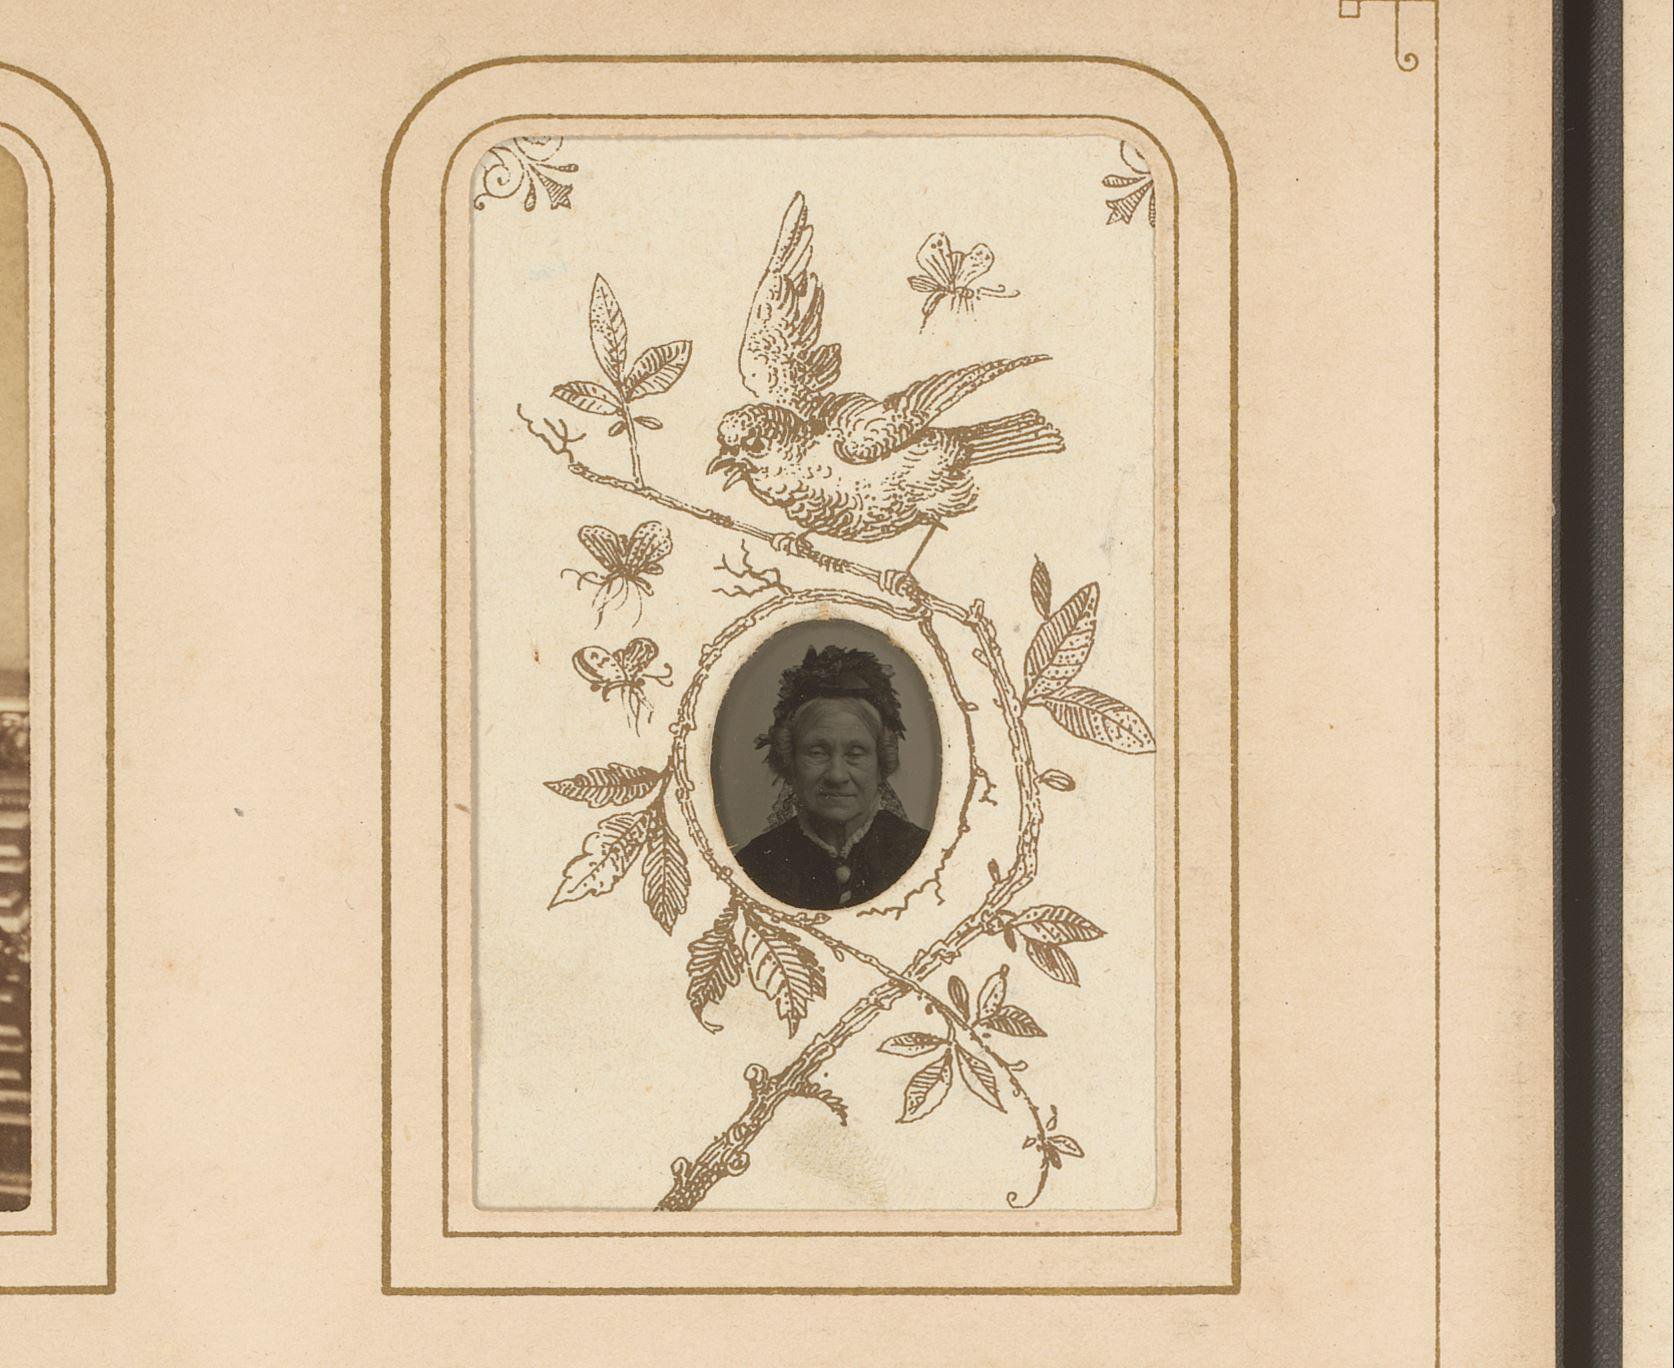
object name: carte de visite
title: Portret van een vrouw met hoofddeksel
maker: t. taylor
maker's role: fotograaf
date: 1880-1910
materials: cardboard, iron, paper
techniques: ferrotyping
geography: brussels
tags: head-gear, historical persons - bb - woman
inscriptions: inscription: ‘Photographie Américaine/ Origine véritable/ 9 Portraits bijoux/ pour UN Franc/ On livre/ immédiatement après la pose/ T. TAYLOR/ 19, rue Neuve, Bruxelles/ GARANTIS PARFAITS’